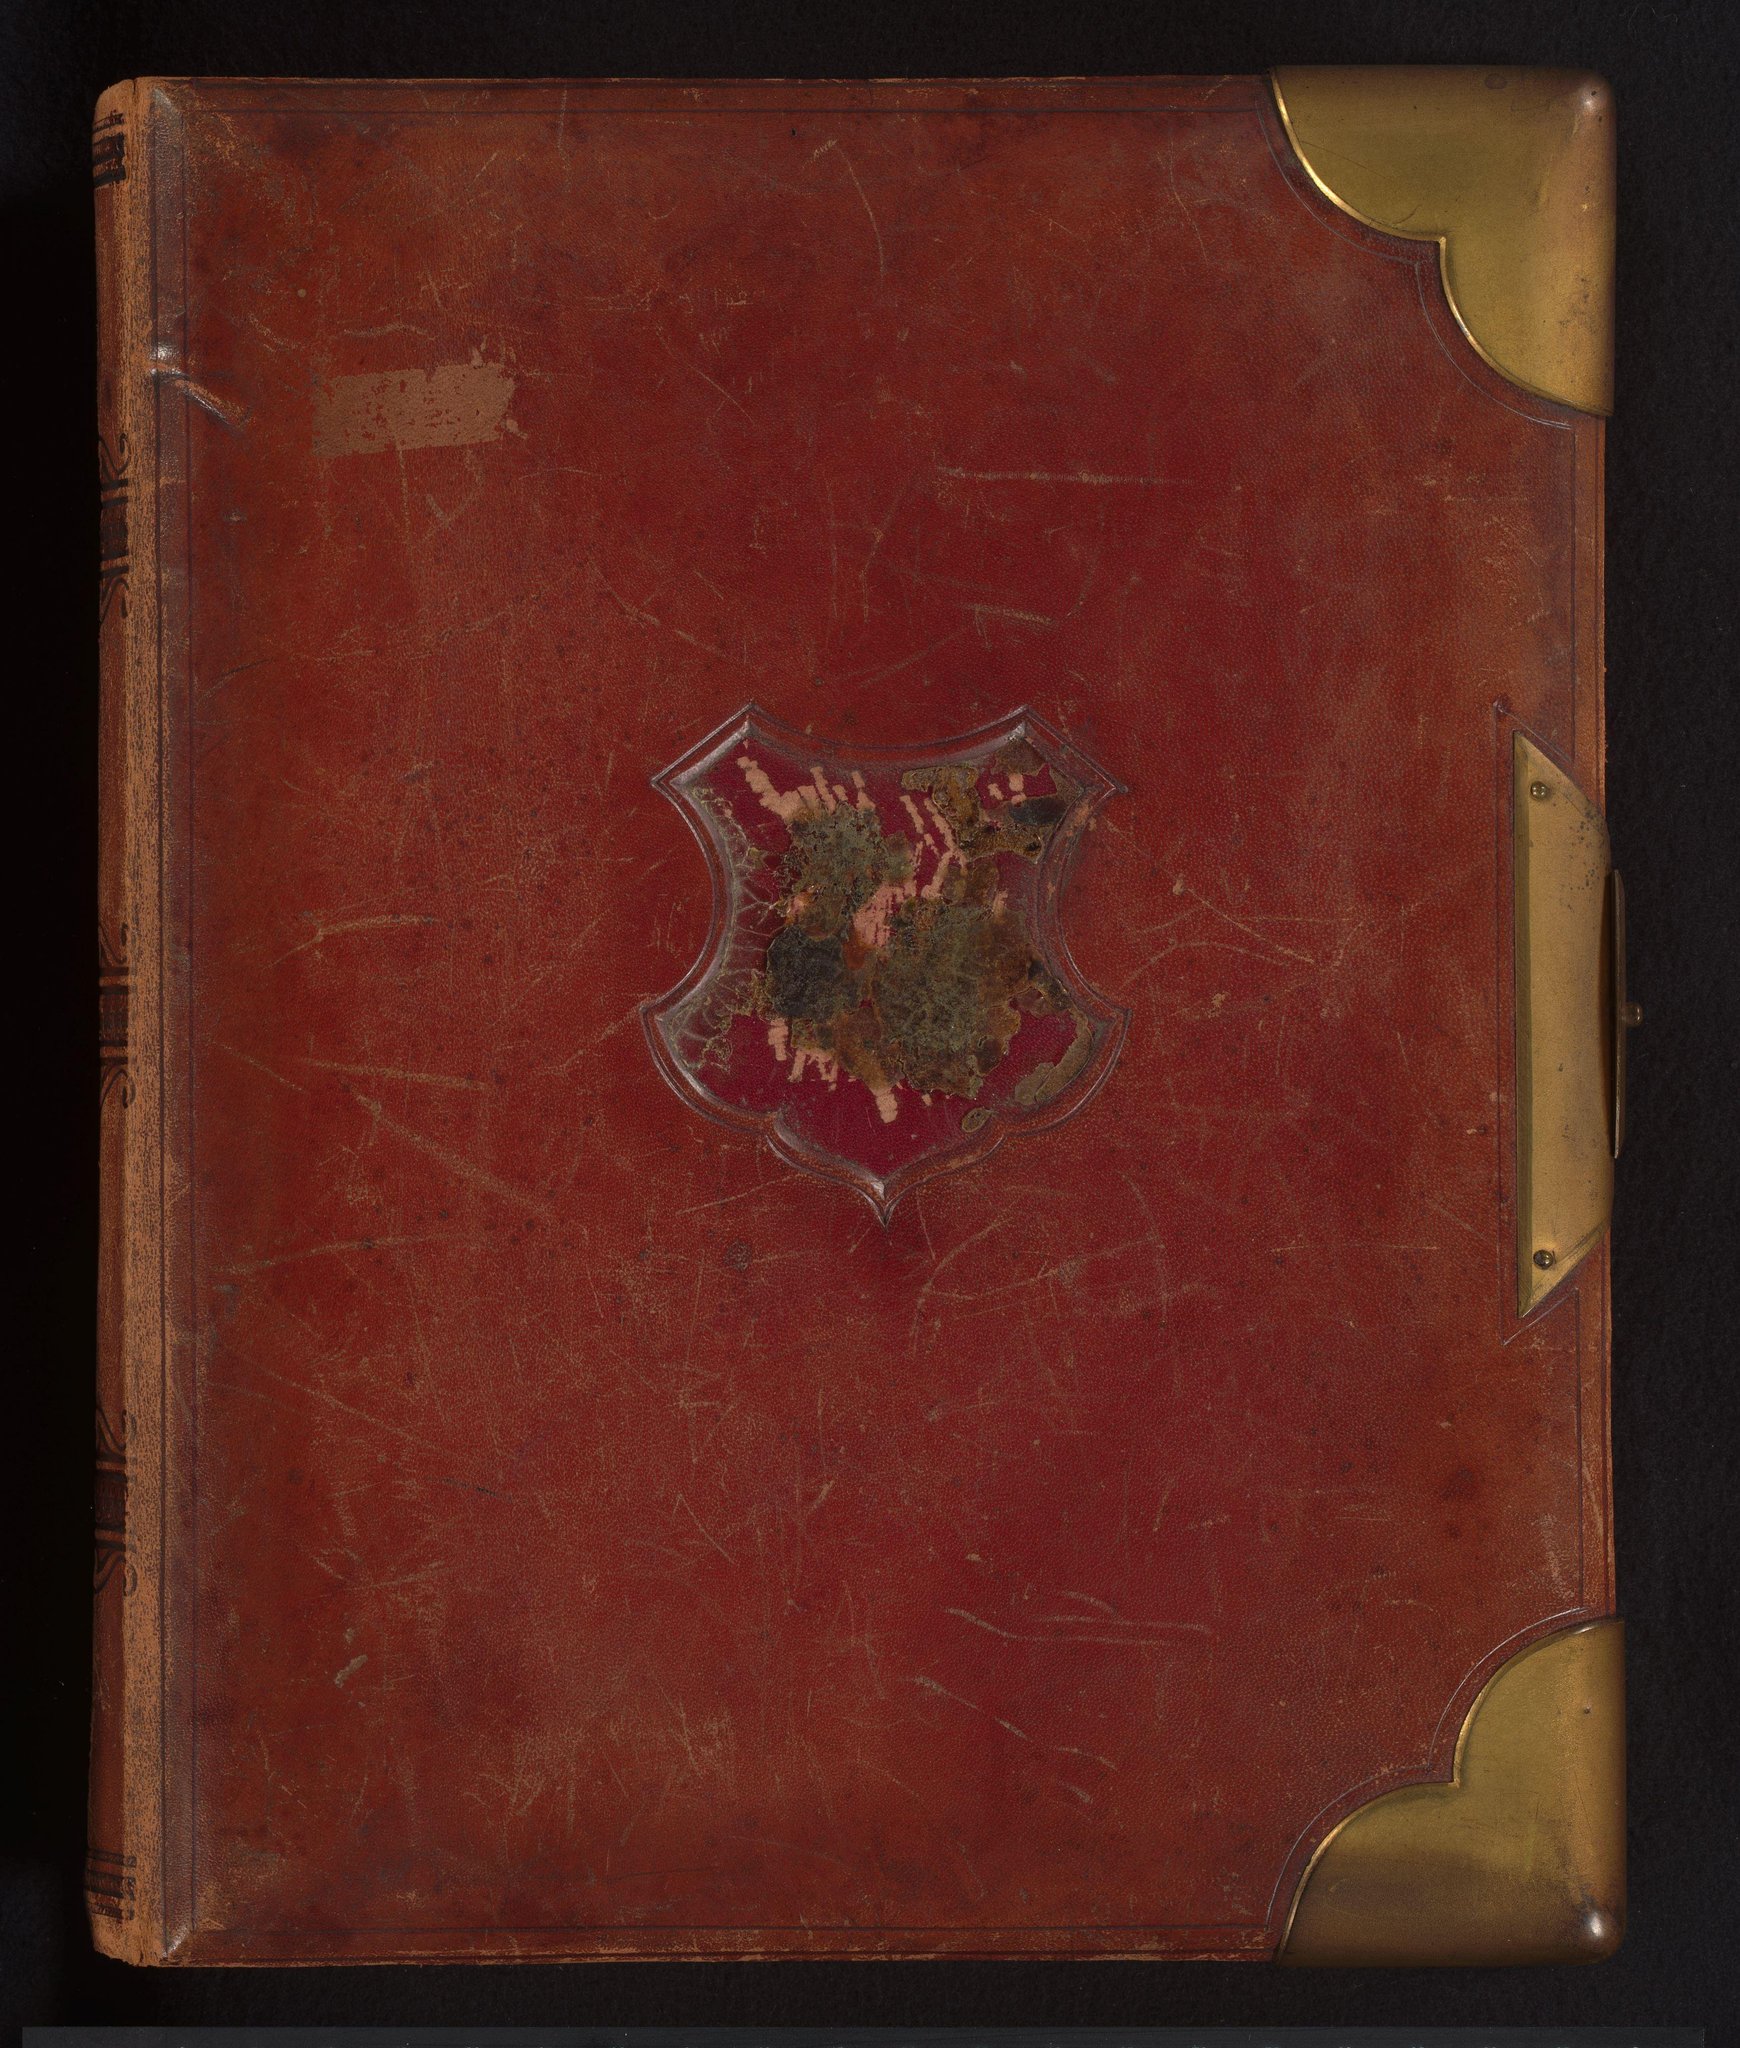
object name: slip in album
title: Fotoalbum met 51 foto's, Nederlands, Indonesisch, Duits en Frans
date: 1860-1900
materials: cardboard, copper, leather, paper, photographic support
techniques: albumen print, decorated paper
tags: historical persons - bb - woman, historical persons, youth, adolescent, (military) uniforms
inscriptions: collector's mark: ‘Dienst Verspreide Rijkskollekties (...) A689’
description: Fotoalbum met 24 bladen met in totaal 51 foto's. Het album bevat 2 kabinetfoto's en 49 cartes-de-visite. Iedere pagina bevat 1 of 4 met gouden lijnen omkaderde passe-partouts voor kabinetfoto's of cartes-de-visite. Niet alle passe-partouts zijn gevuld. Afgebeeld zijn koning Willem III, koningin Emma en prinses Maria Elisabeth Louise Frederika van Pruisen naast portretten van onbekende mannen, vrouwen en kinderen. De foto's zijn vervaardigd door verschillende fotografen, waaronder James Page, Wegner & Mottu en J. Schäfer. De foto's zijn vervaardigd in Nederland, Indonesië, Duitsland en Frankrijk. Van enkele foto's is de vervaardiger anoniem. De laatste 3 foto's in het album zijn reproducties van schilderijen en prenten.